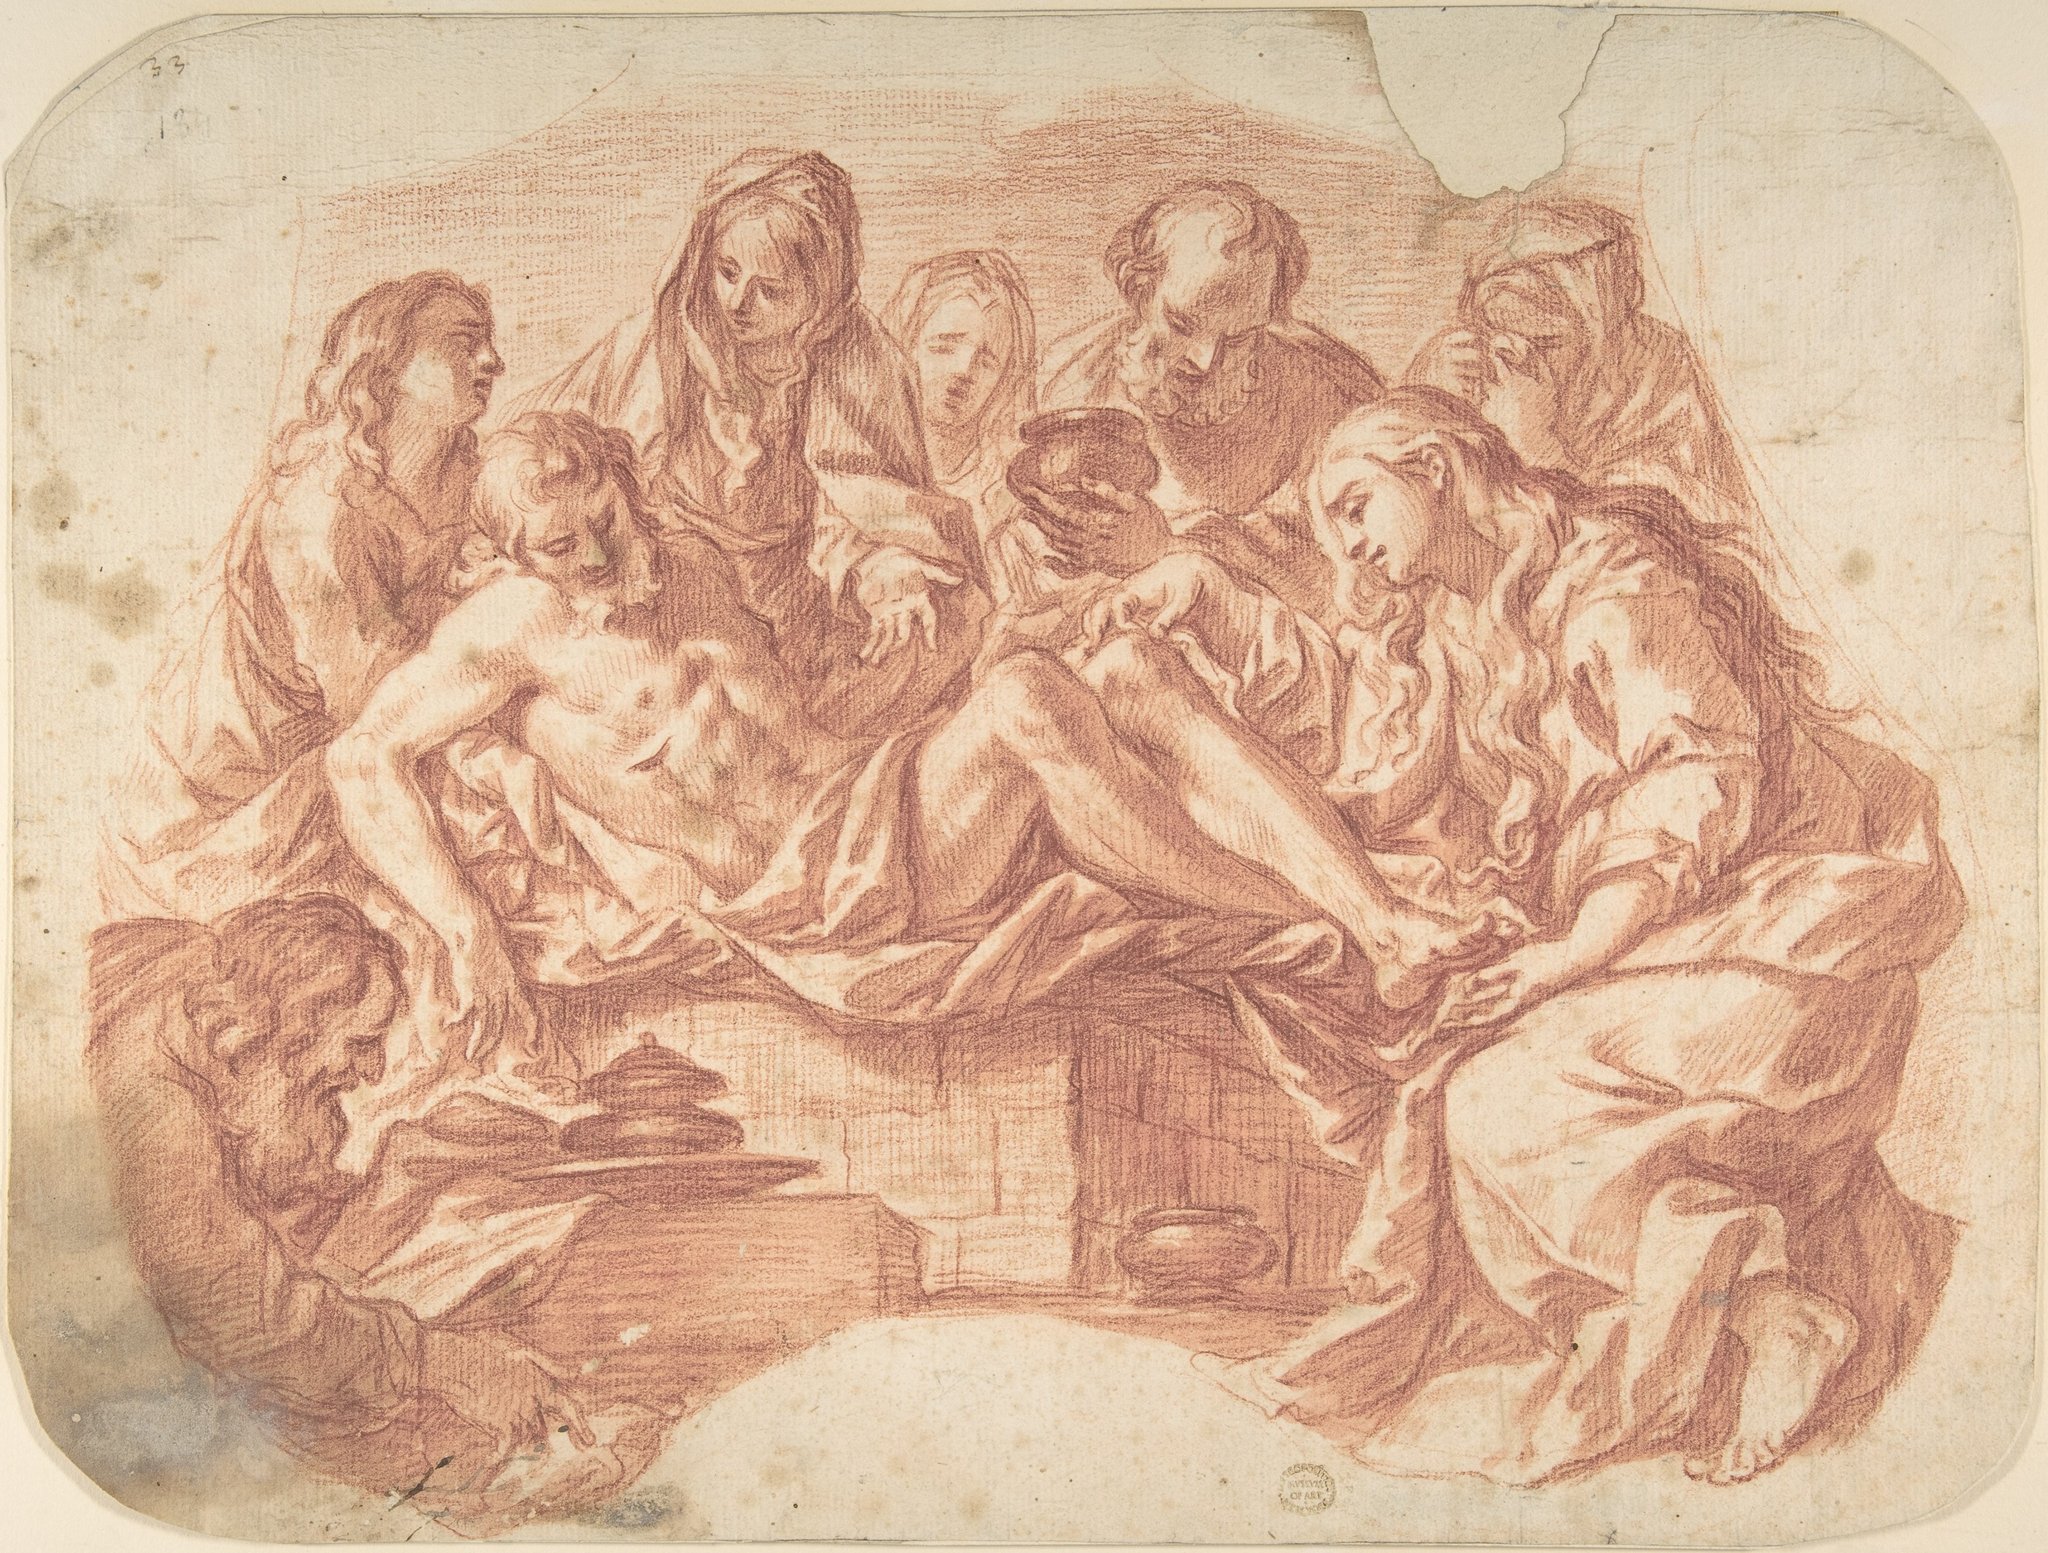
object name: drawing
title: The Entombment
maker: johann friedrich overbeck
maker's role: former attribution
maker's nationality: german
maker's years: 1789-1869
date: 1701-1800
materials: chalk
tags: christ,entombment